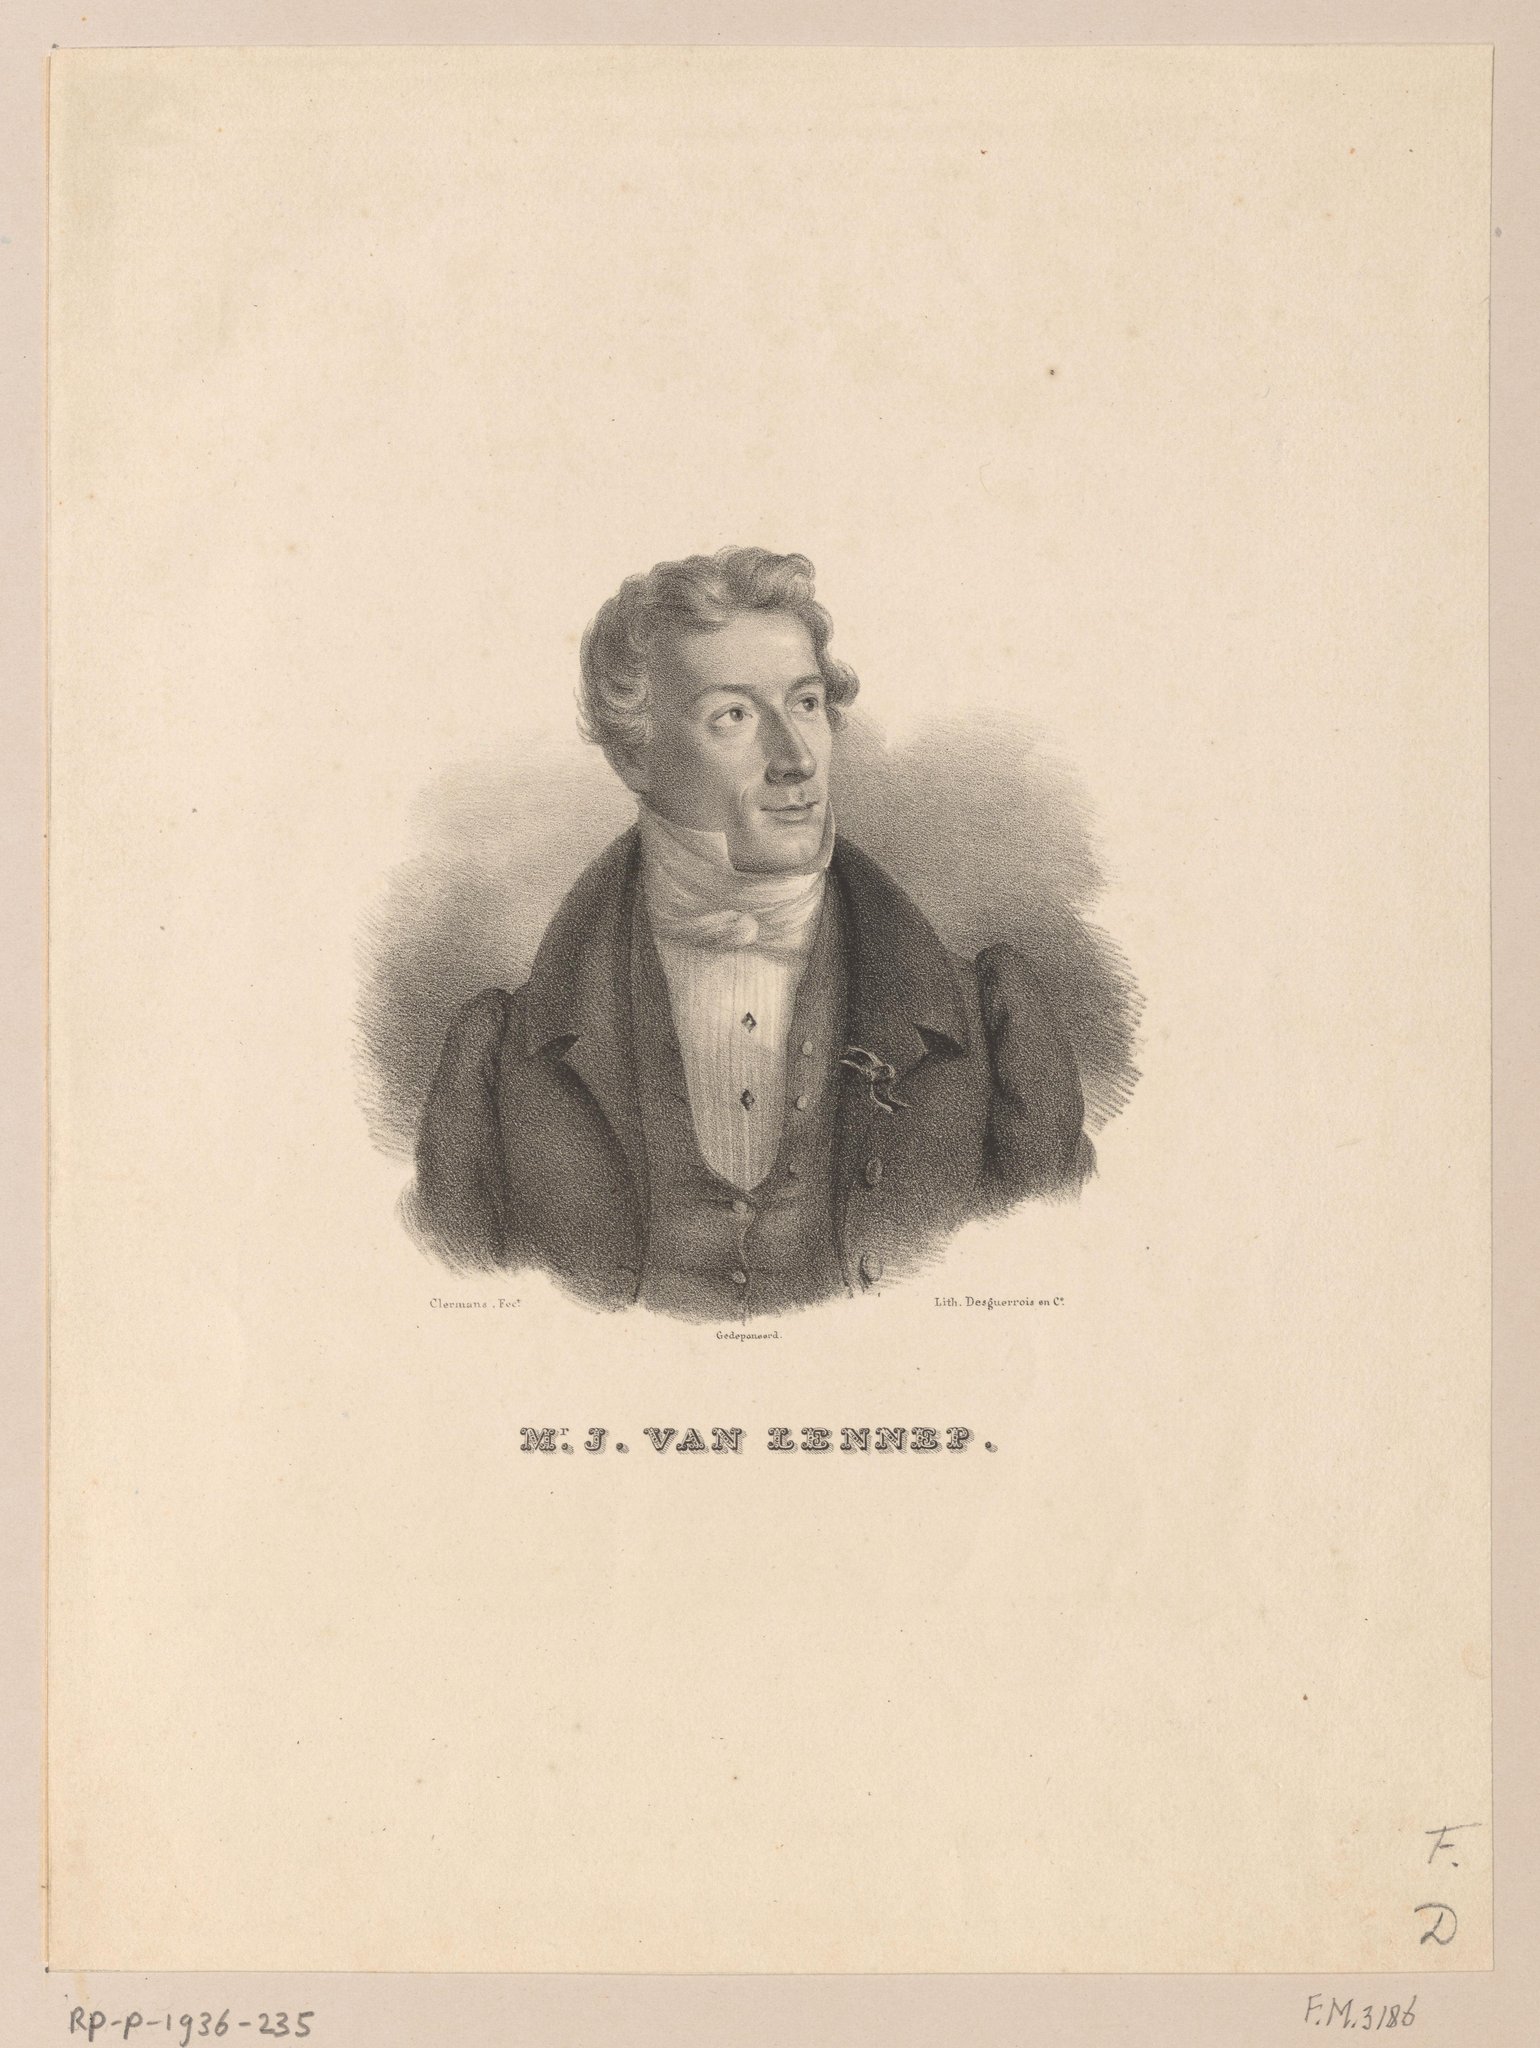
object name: print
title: Portret van Jacob van Lennep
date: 1827-1839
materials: paper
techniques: lithograph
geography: amsterdam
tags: amsterdam, jacob van lennep, historical persons, portrait of a writer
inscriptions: collector's mark: Lugt 2760, collector's mark: Lugt 2228, : ‘Gedeponeerd.’